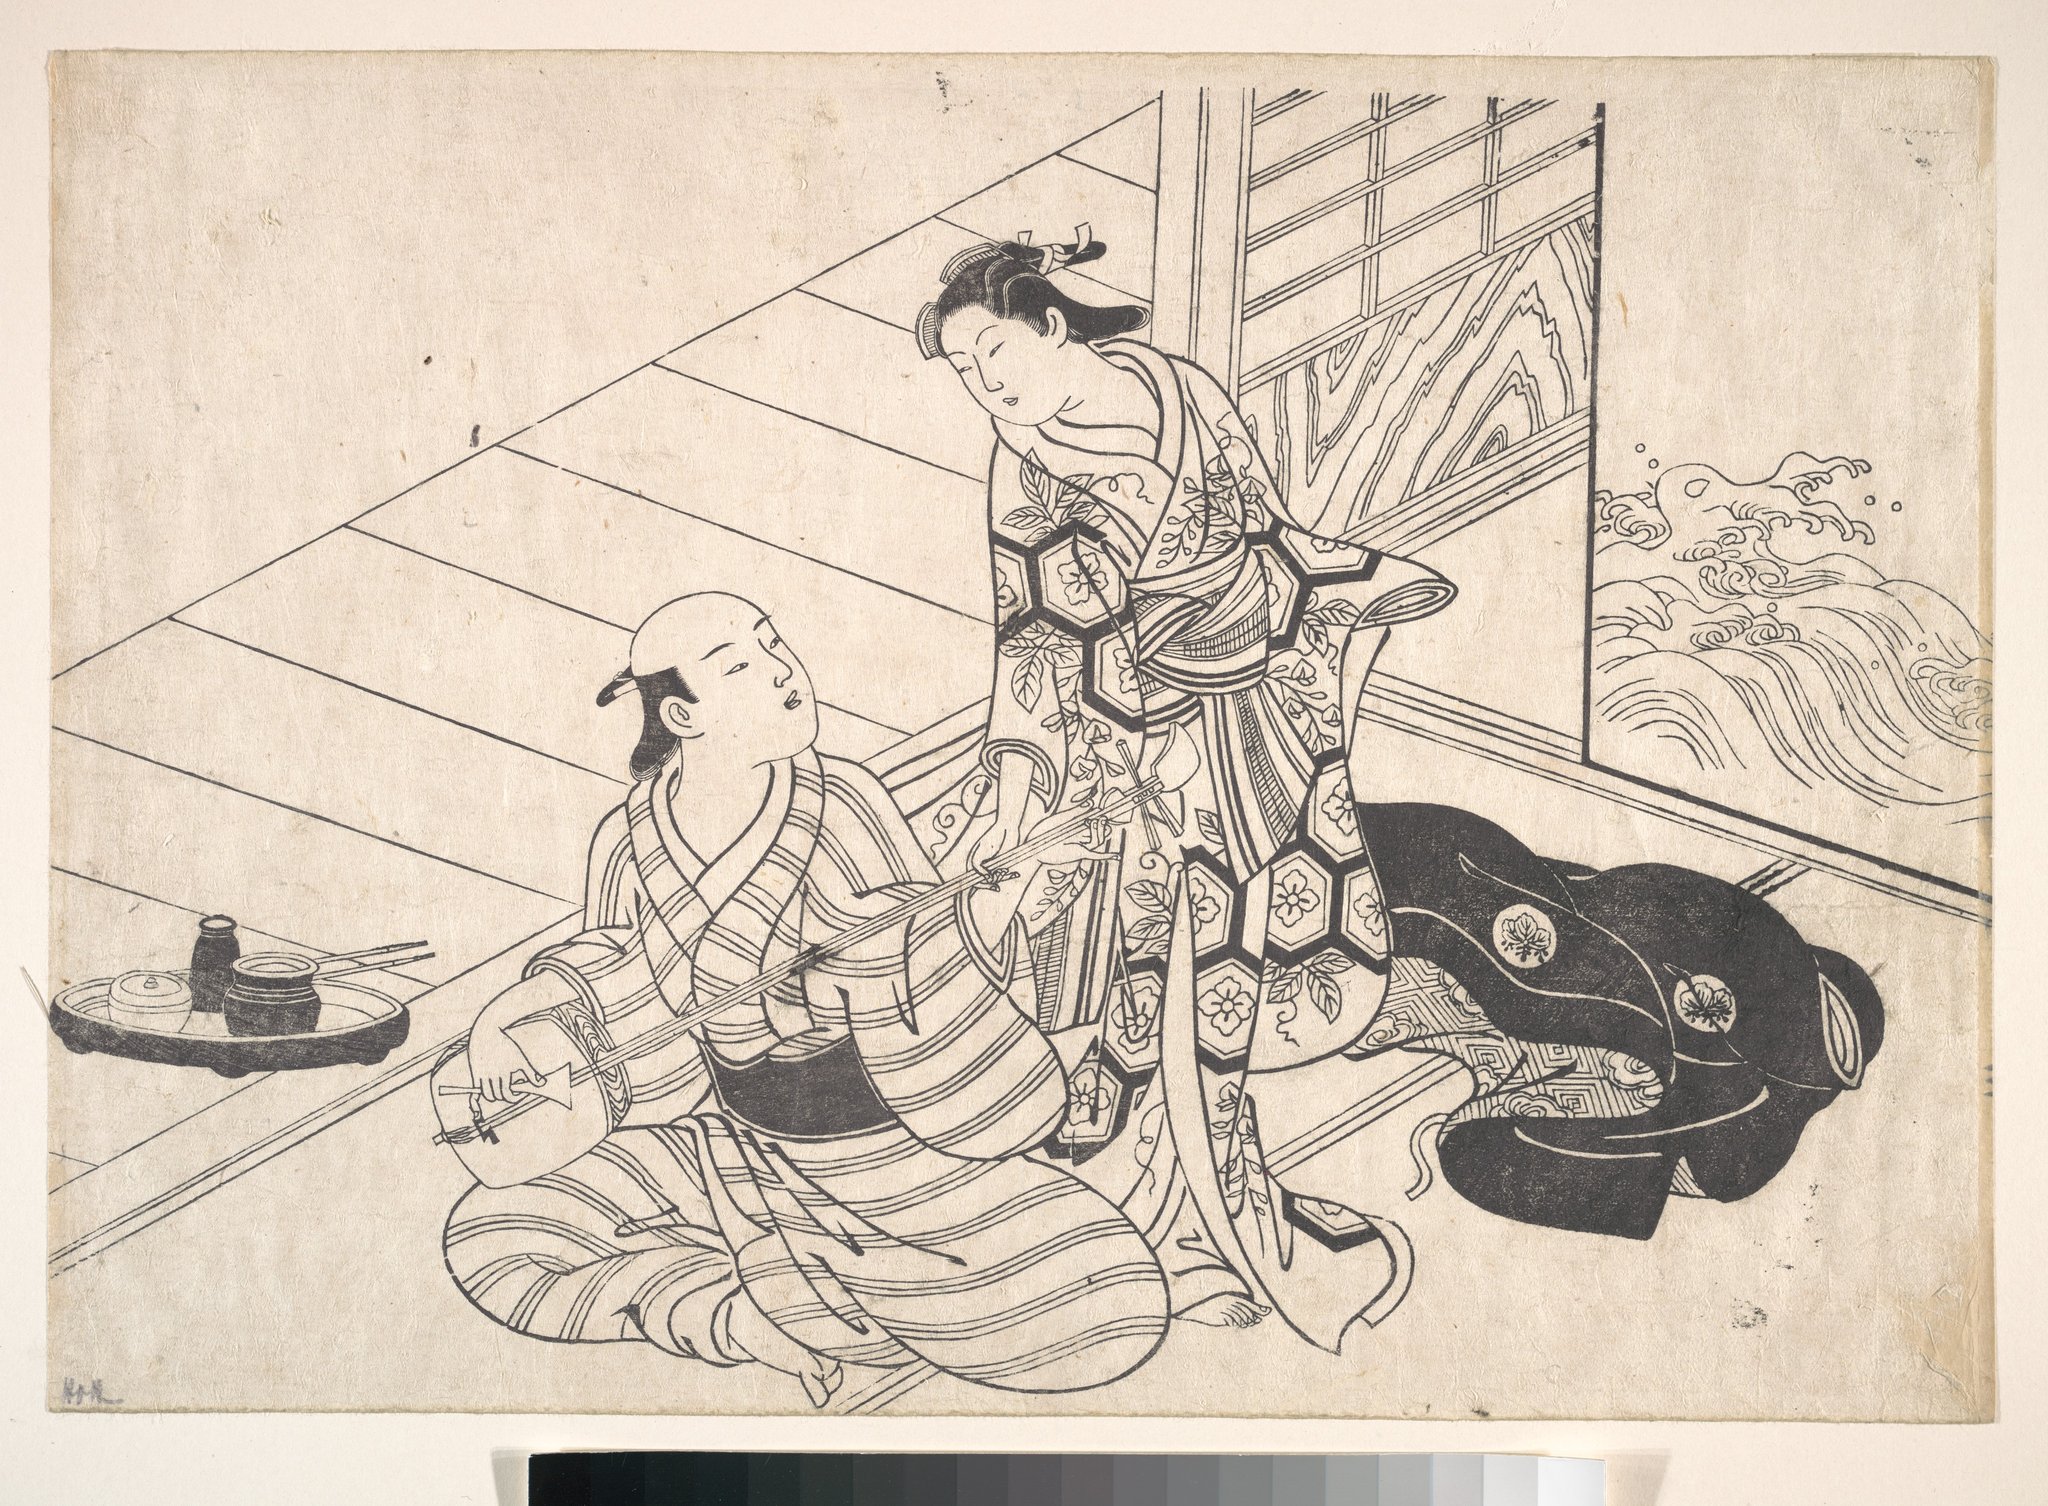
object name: print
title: Lady Interrupting Her Lover, who is Playing the Shamisen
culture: japanese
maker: nishikawa sukenobu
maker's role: artist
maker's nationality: japanese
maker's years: 1671-1750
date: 1671-1751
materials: ink, paper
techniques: woodblock print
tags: musical instruments,men,lovers,women